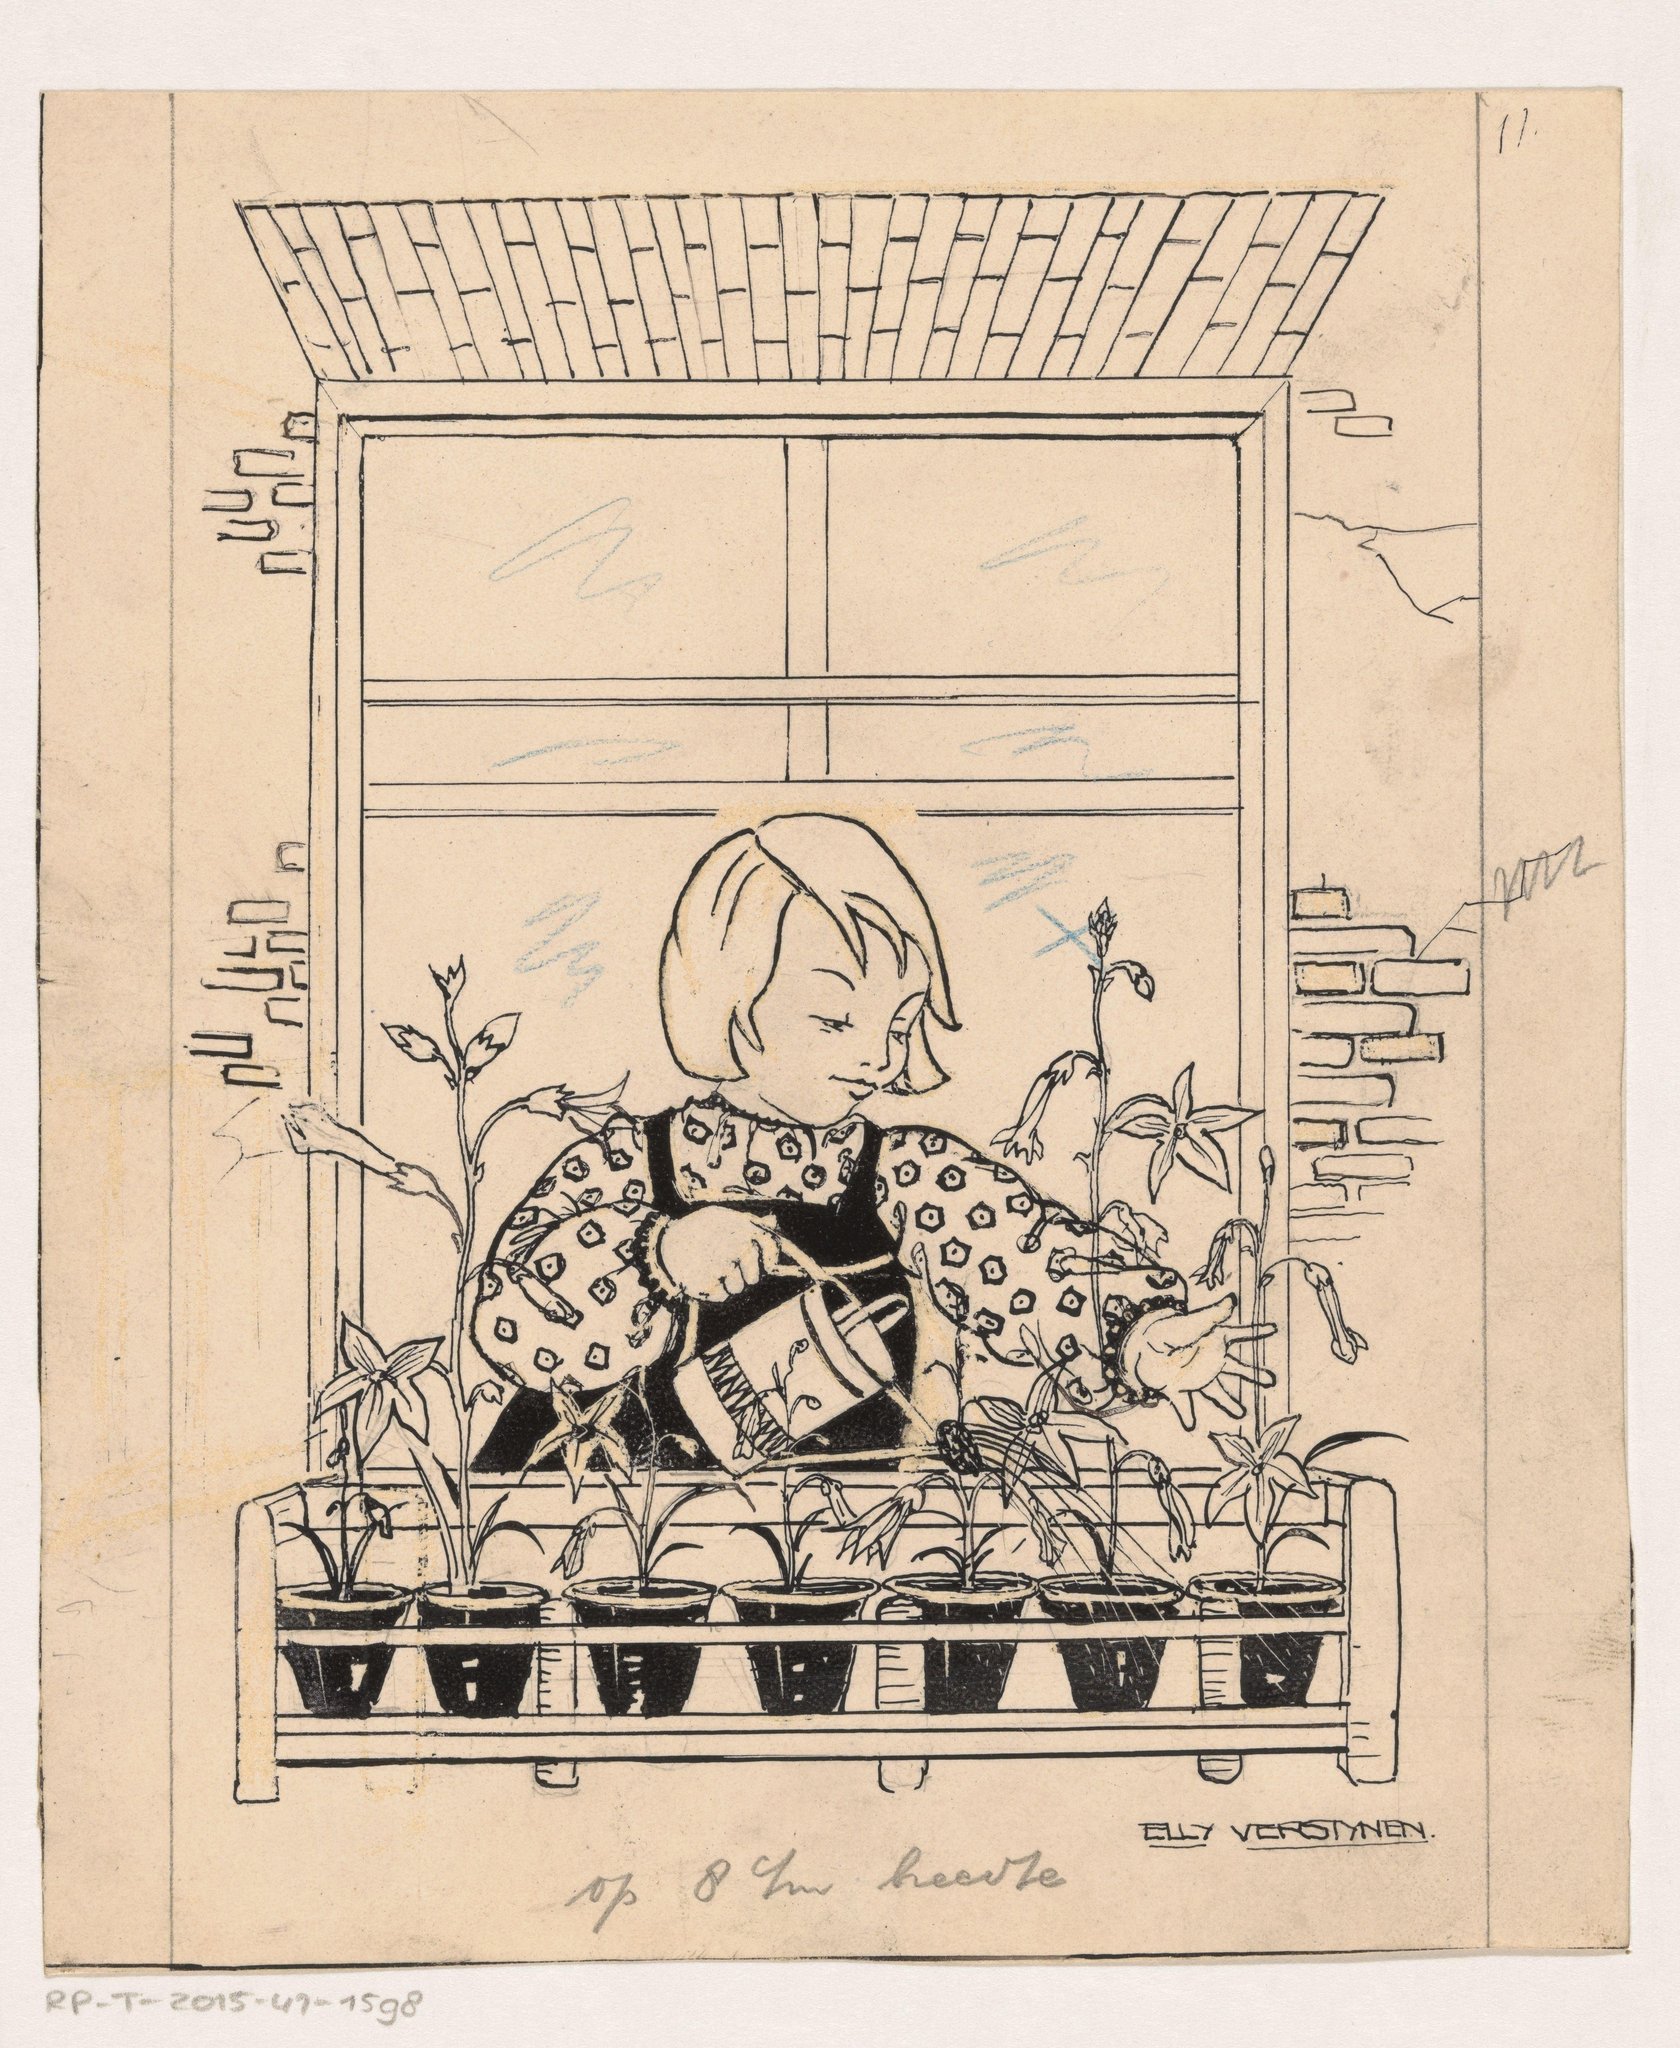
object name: boekillustratie ontwerp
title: Meisje geeft planten water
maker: elly verstijnen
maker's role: draughtsman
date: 1900-1930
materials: ink, paper, pencil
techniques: brush, pen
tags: window, watering plants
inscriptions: collector's mark: Lugt 2228, signature: ‘ELLY VERSTYNEN.’, :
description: Een meisje staat bij een open raam en geeft planten water die in een bak staan die aan de vensterbank hangt.